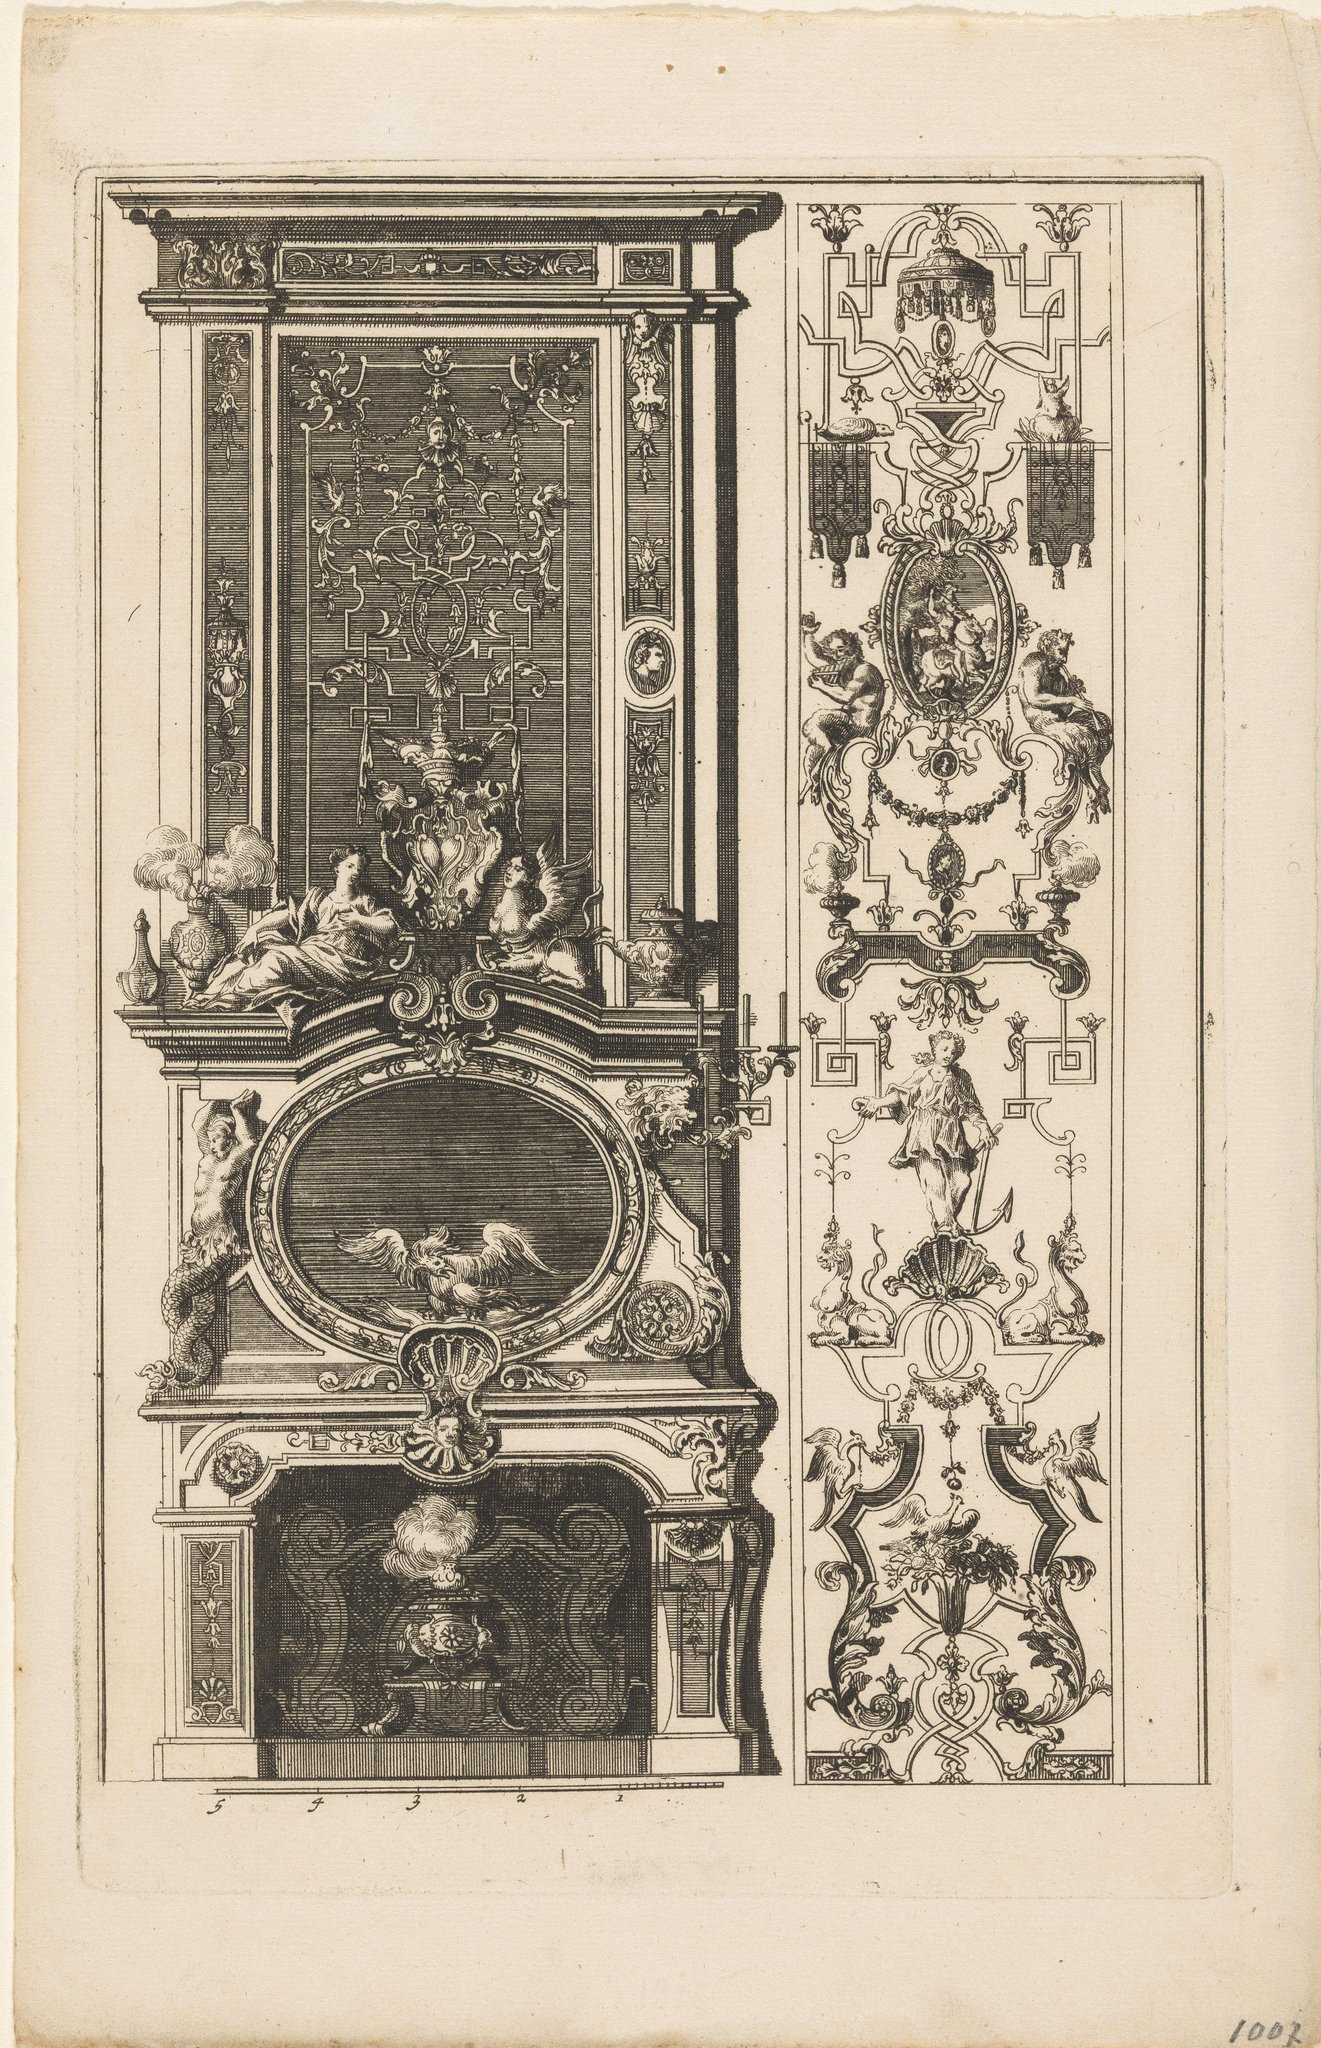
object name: ornament print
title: Schoorsteenmantel met een feniks en vrouwenfiguren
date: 1708-1724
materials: paper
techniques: etching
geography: nuremberg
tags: ornament ~ grotesque, interior of the house, chimney-piece, mantelpiece, fabulous animals ~ birds: phoenix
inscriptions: collector's mark: Lugt 2760, collector's mark: Lugt 2228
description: Boven en rechts grotesken. In het midden een zittende vrouw en een gevleugelde sfinx aan weerszijden van een cartouche. Daaronder een meermin en een feniks.